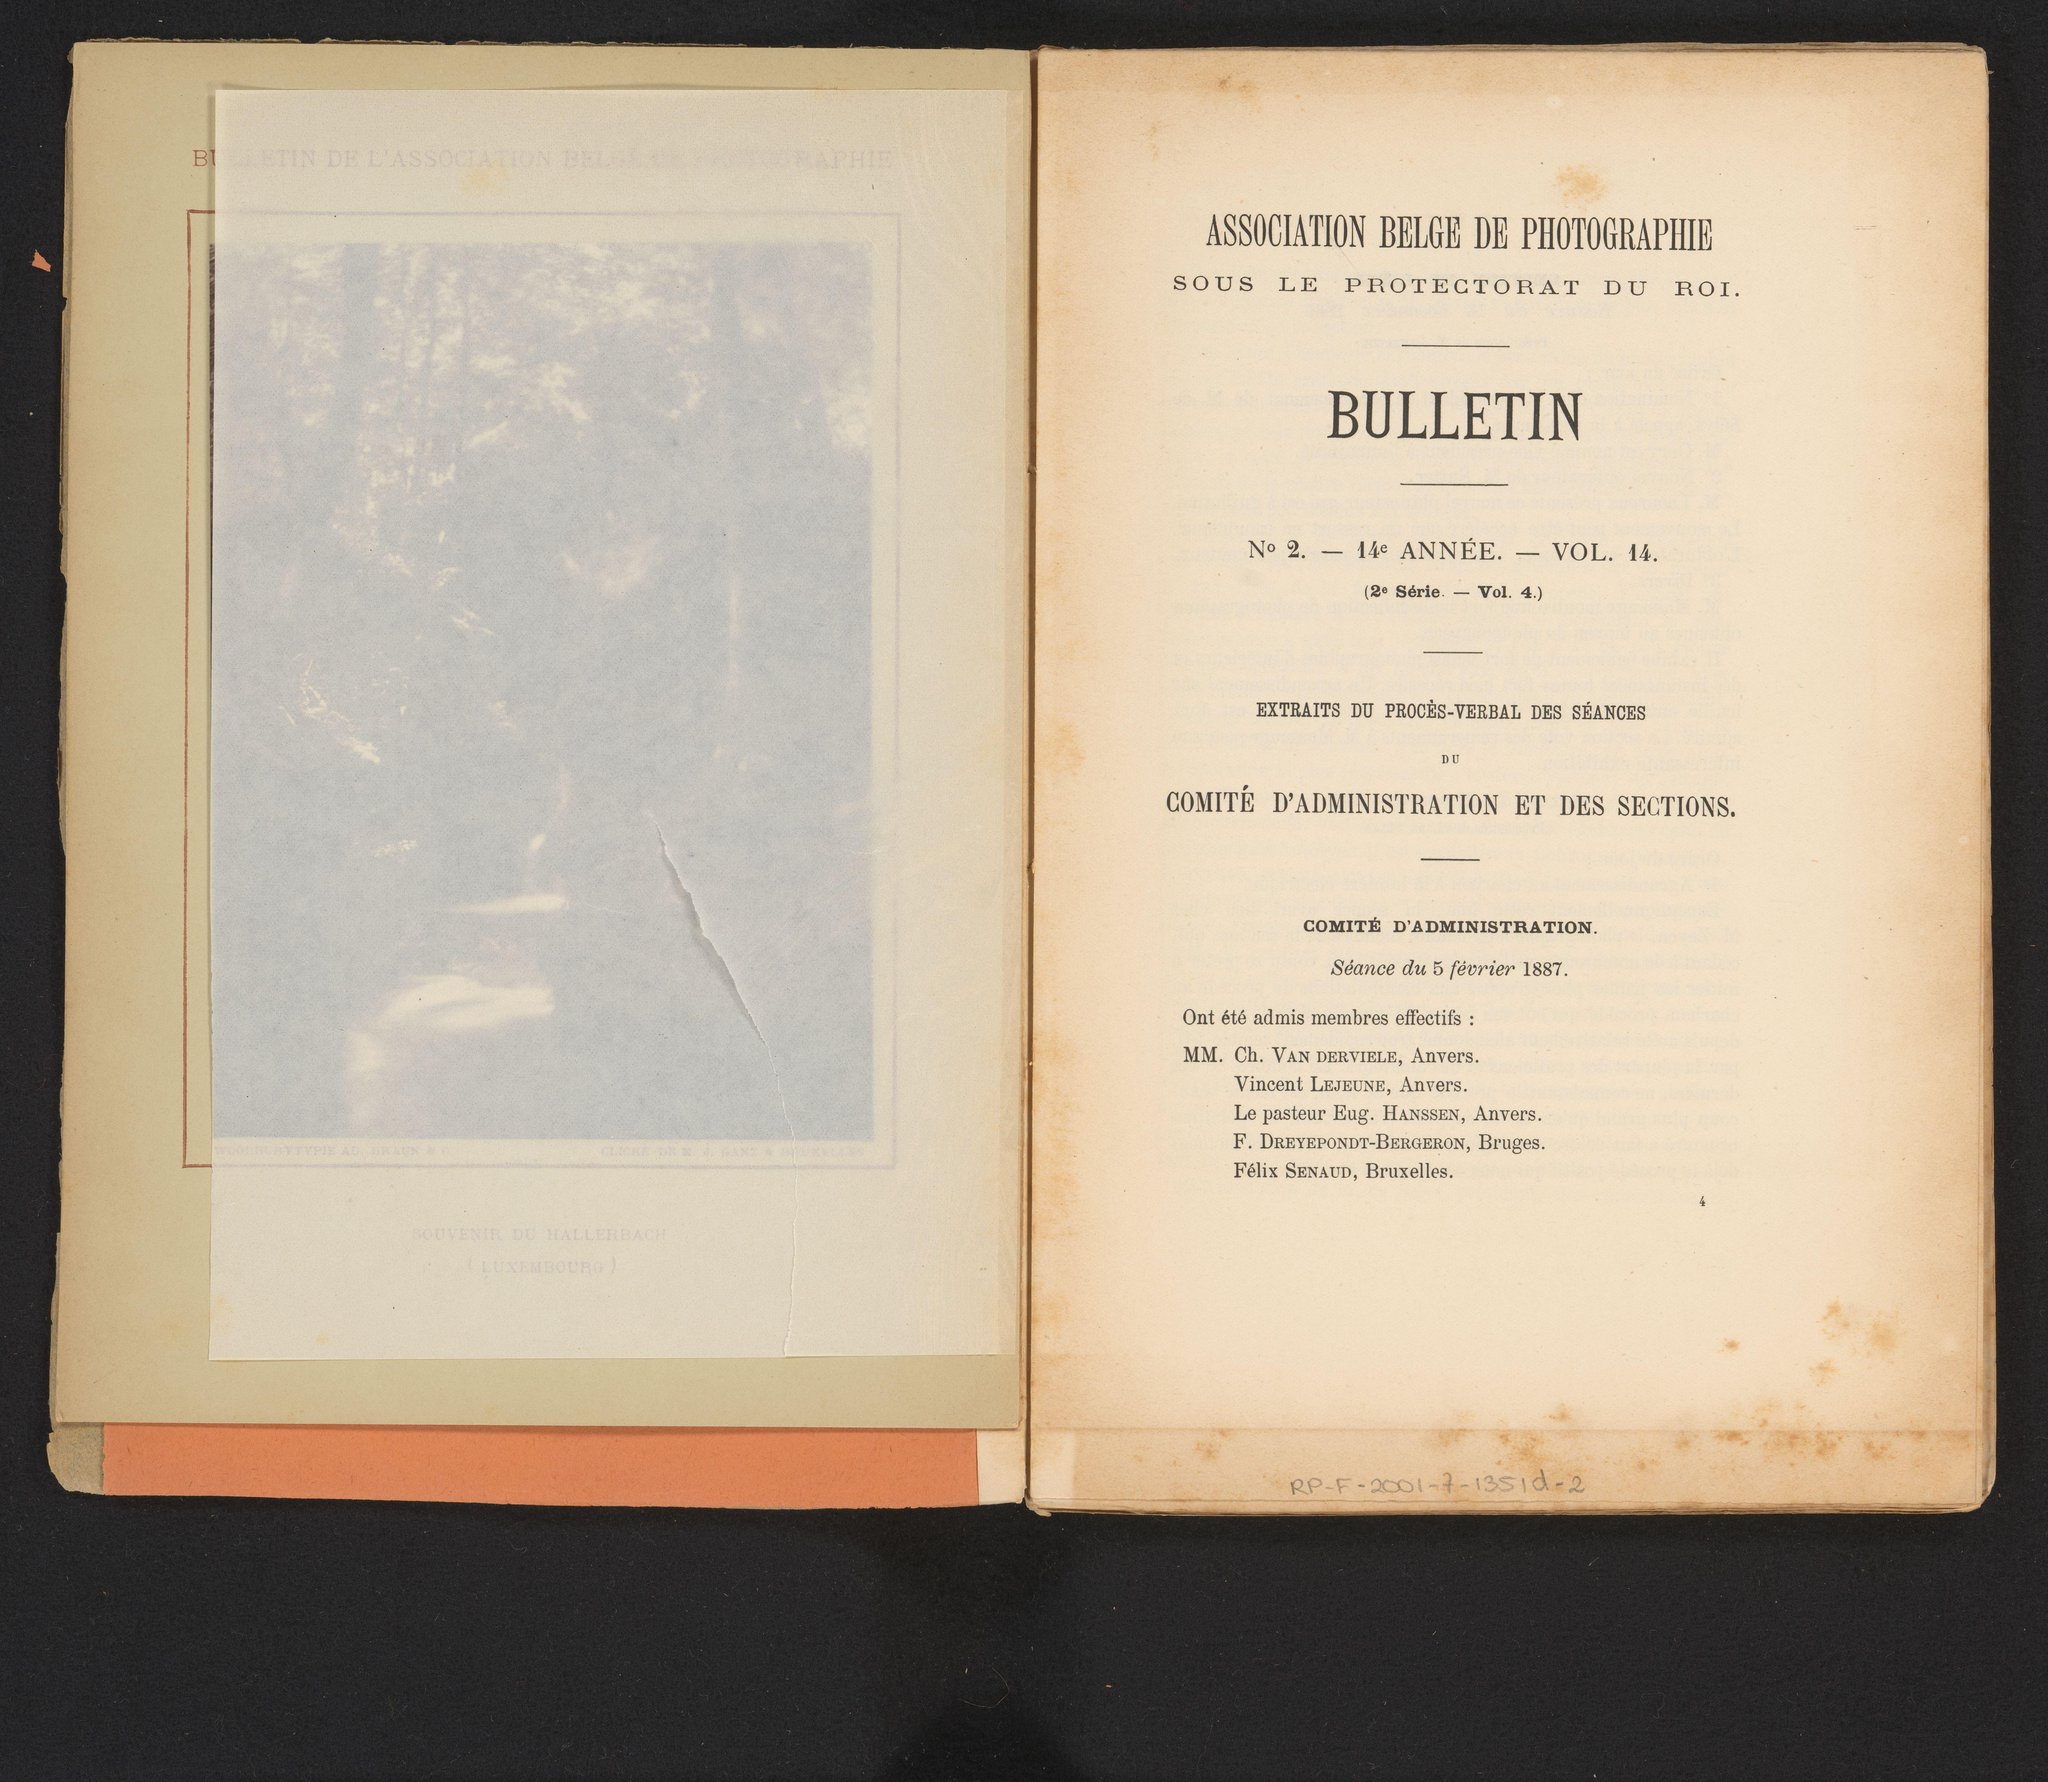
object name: book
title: Bulletin / Association belge de photographie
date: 1802-1887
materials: paper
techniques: printing, engraving, woodburytype